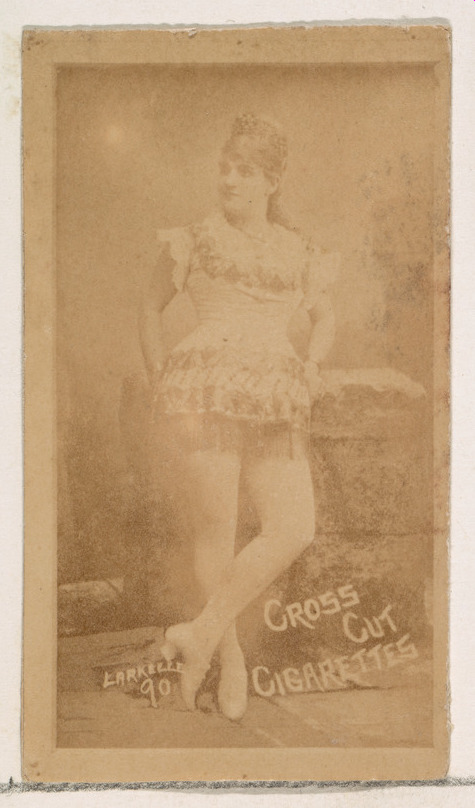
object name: print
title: Card Number 90, Larkelle, from the Actors and Actresses series (N145-1) issued by Duke Sons & Co. to promote Cross Cut Cigarettes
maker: w. duke, sons & co.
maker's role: publisher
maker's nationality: american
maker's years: 1870-1920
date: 1880-1889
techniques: albumen silver print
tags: portraits,women,actresses